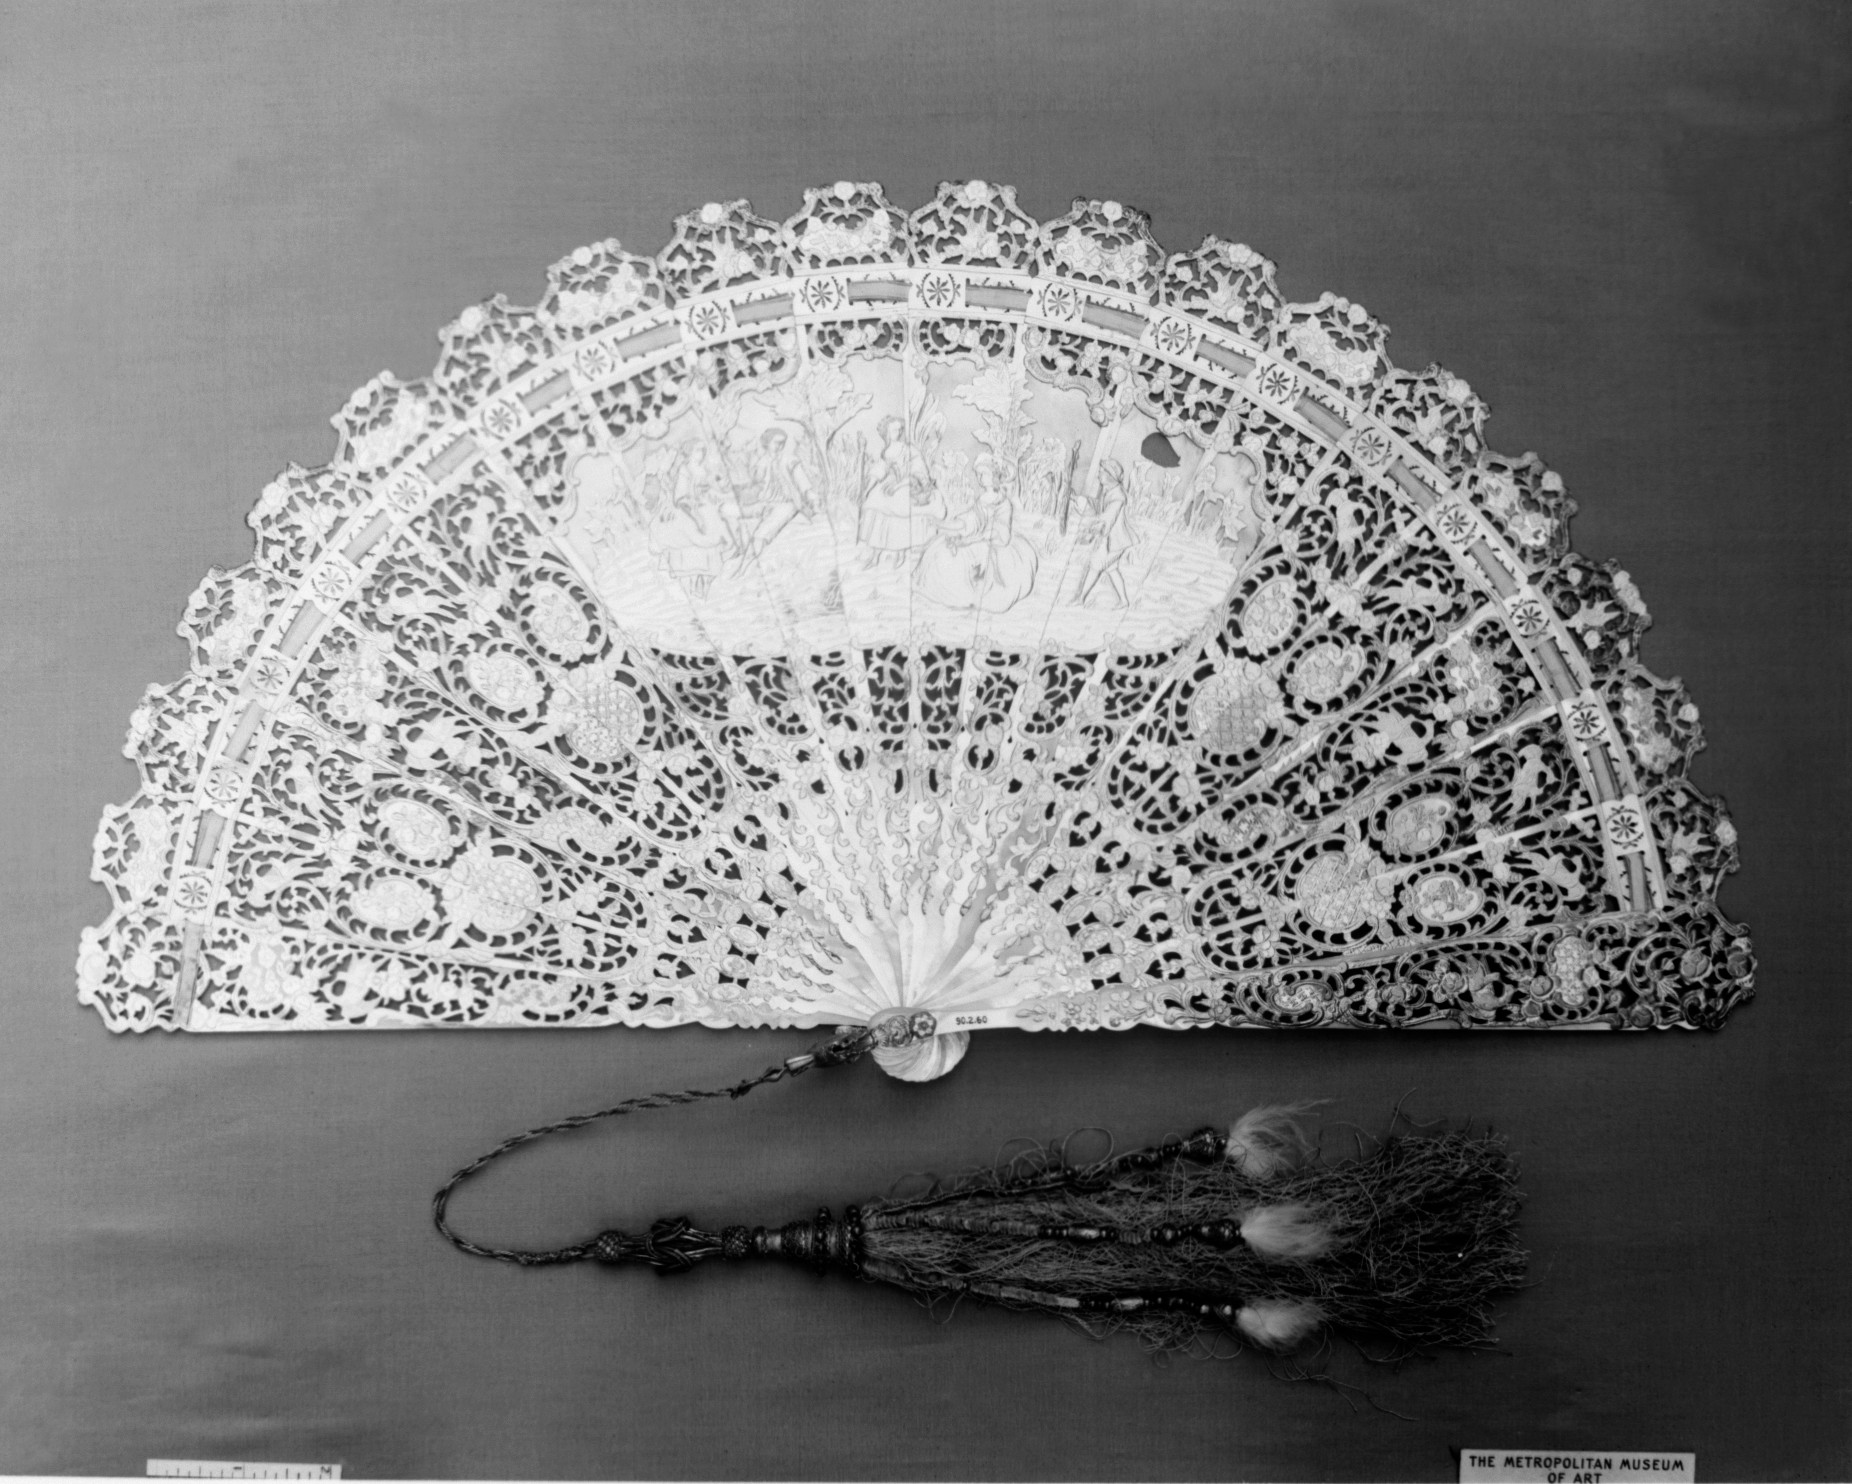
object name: fan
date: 1830-1850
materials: gold, mother of pearl, silk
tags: men,women